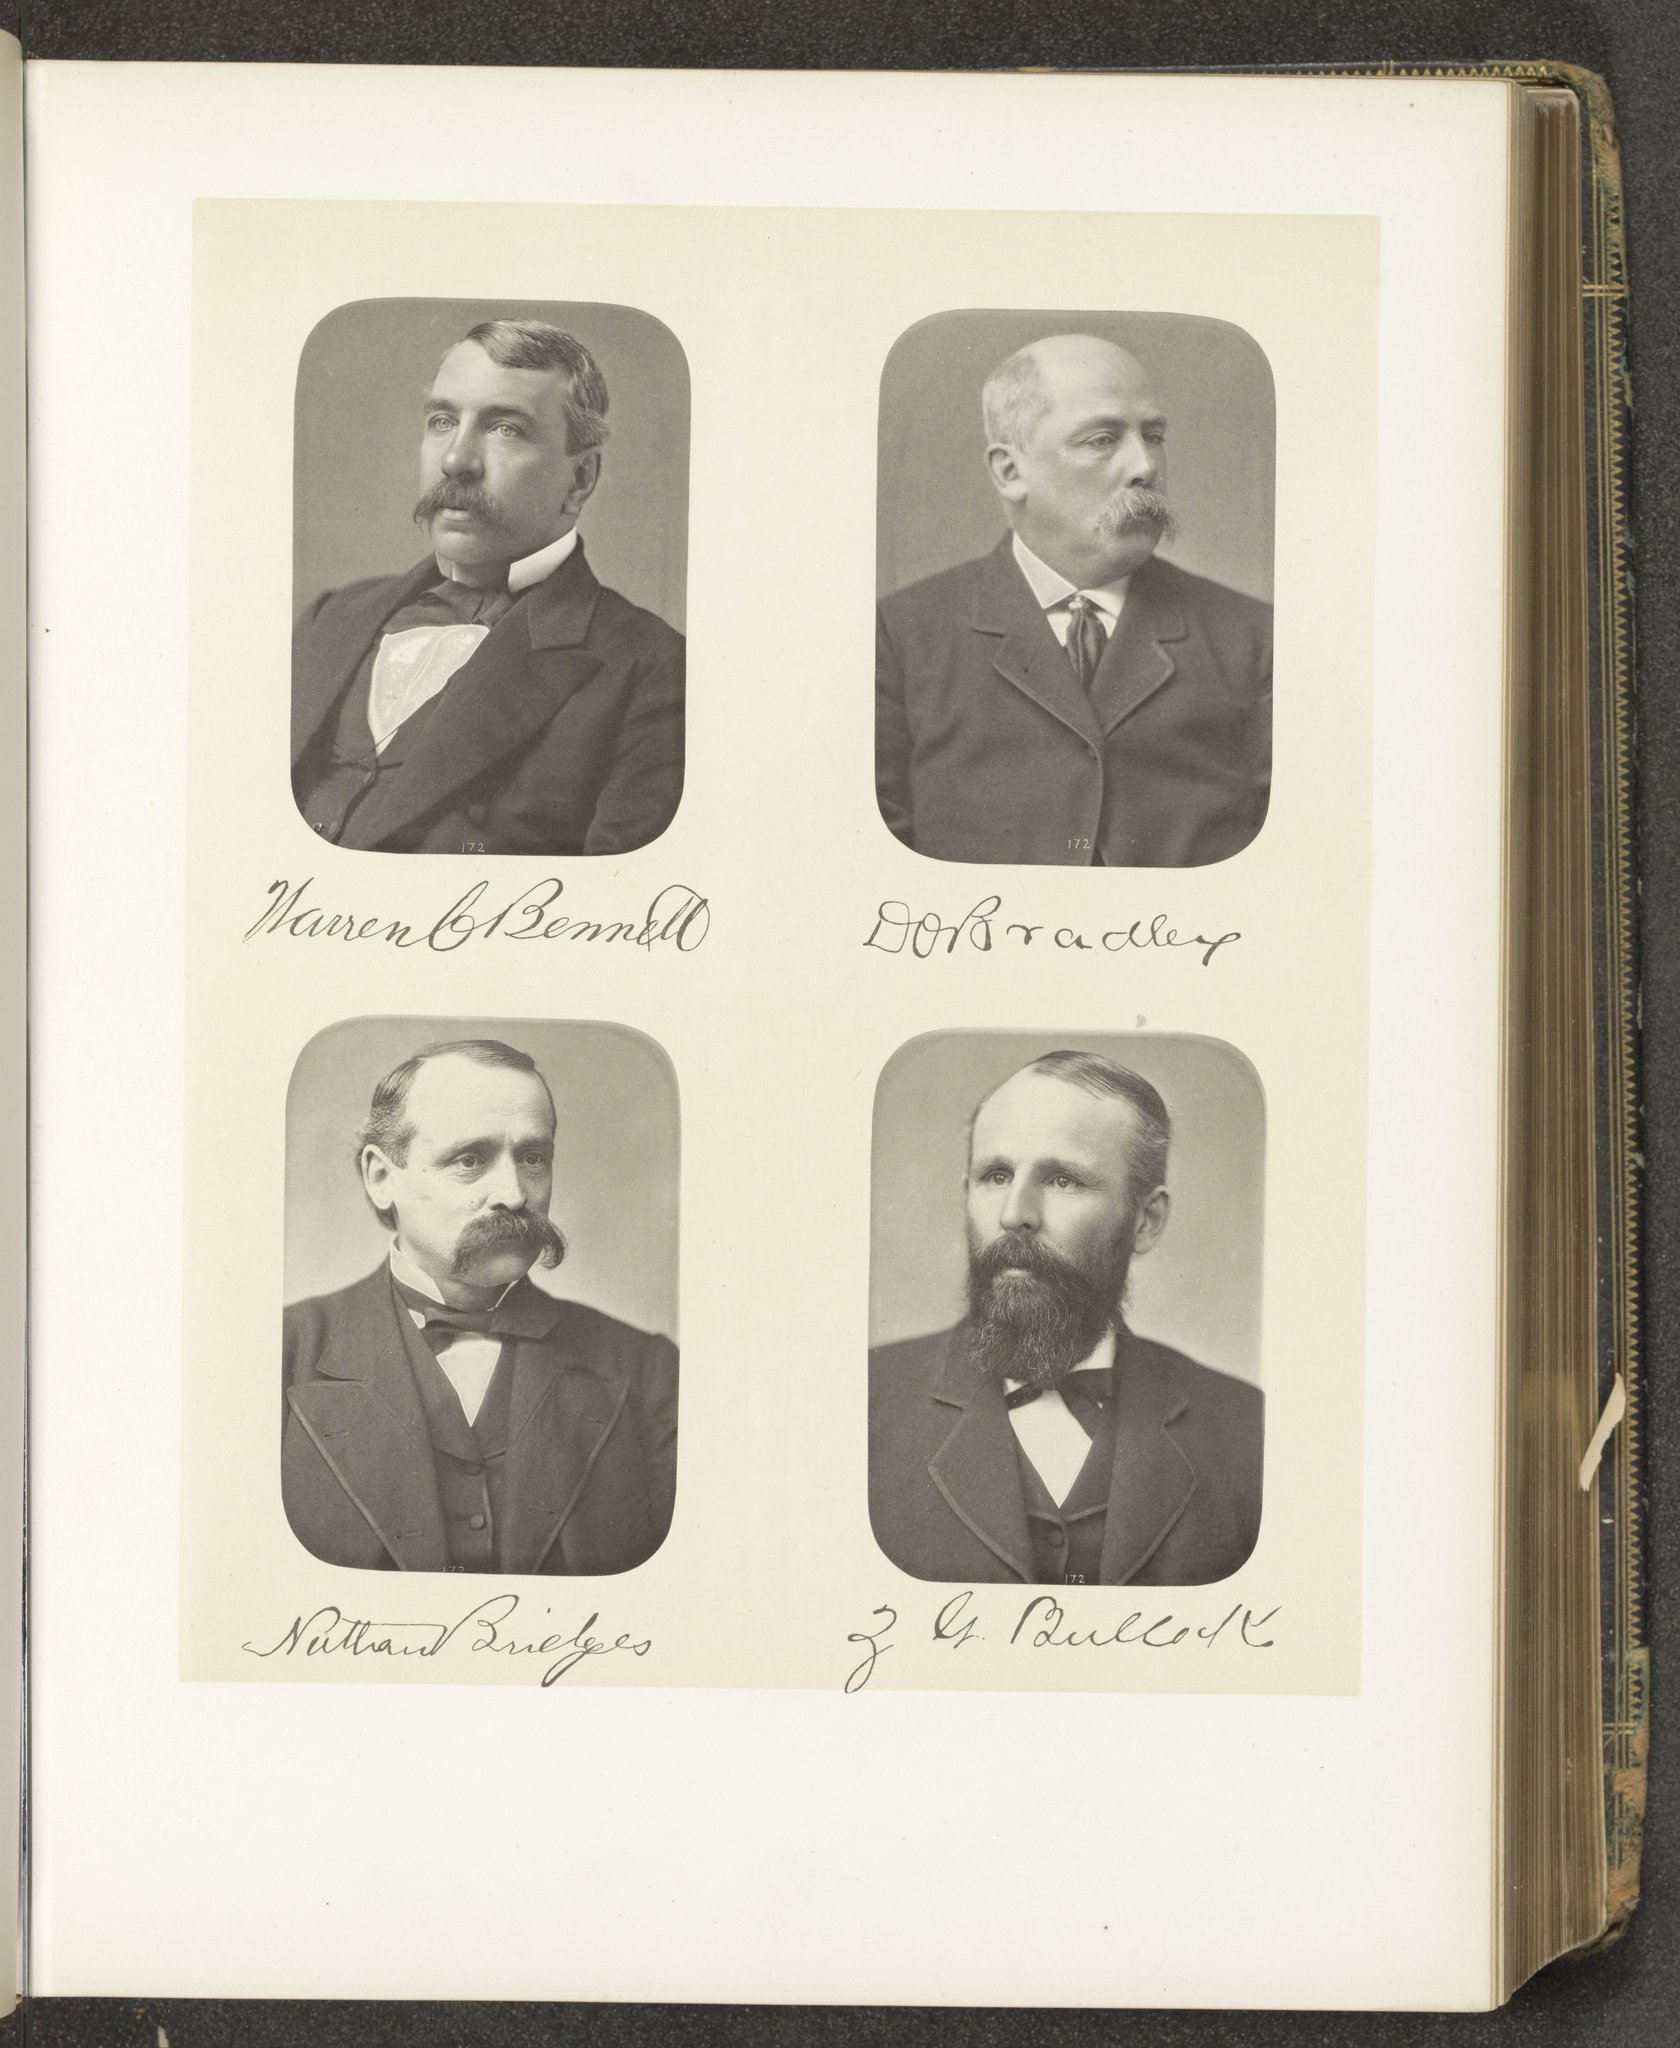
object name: page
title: Portretten van vier leden van het Lagerhuis van de staat New York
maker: Anonymous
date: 1872-1882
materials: paper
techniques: photograph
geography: united states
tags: historical persons (portraits and scenes from the life) (+ head (and shoulders) (portrait))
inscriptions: annotation, number: ‘172’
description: Linksboven Warren C. Bennett, rechtsboven D. Ogden Bradley, linksonder Nathan Bridges, rechtsonder Zenas G. Bullock.